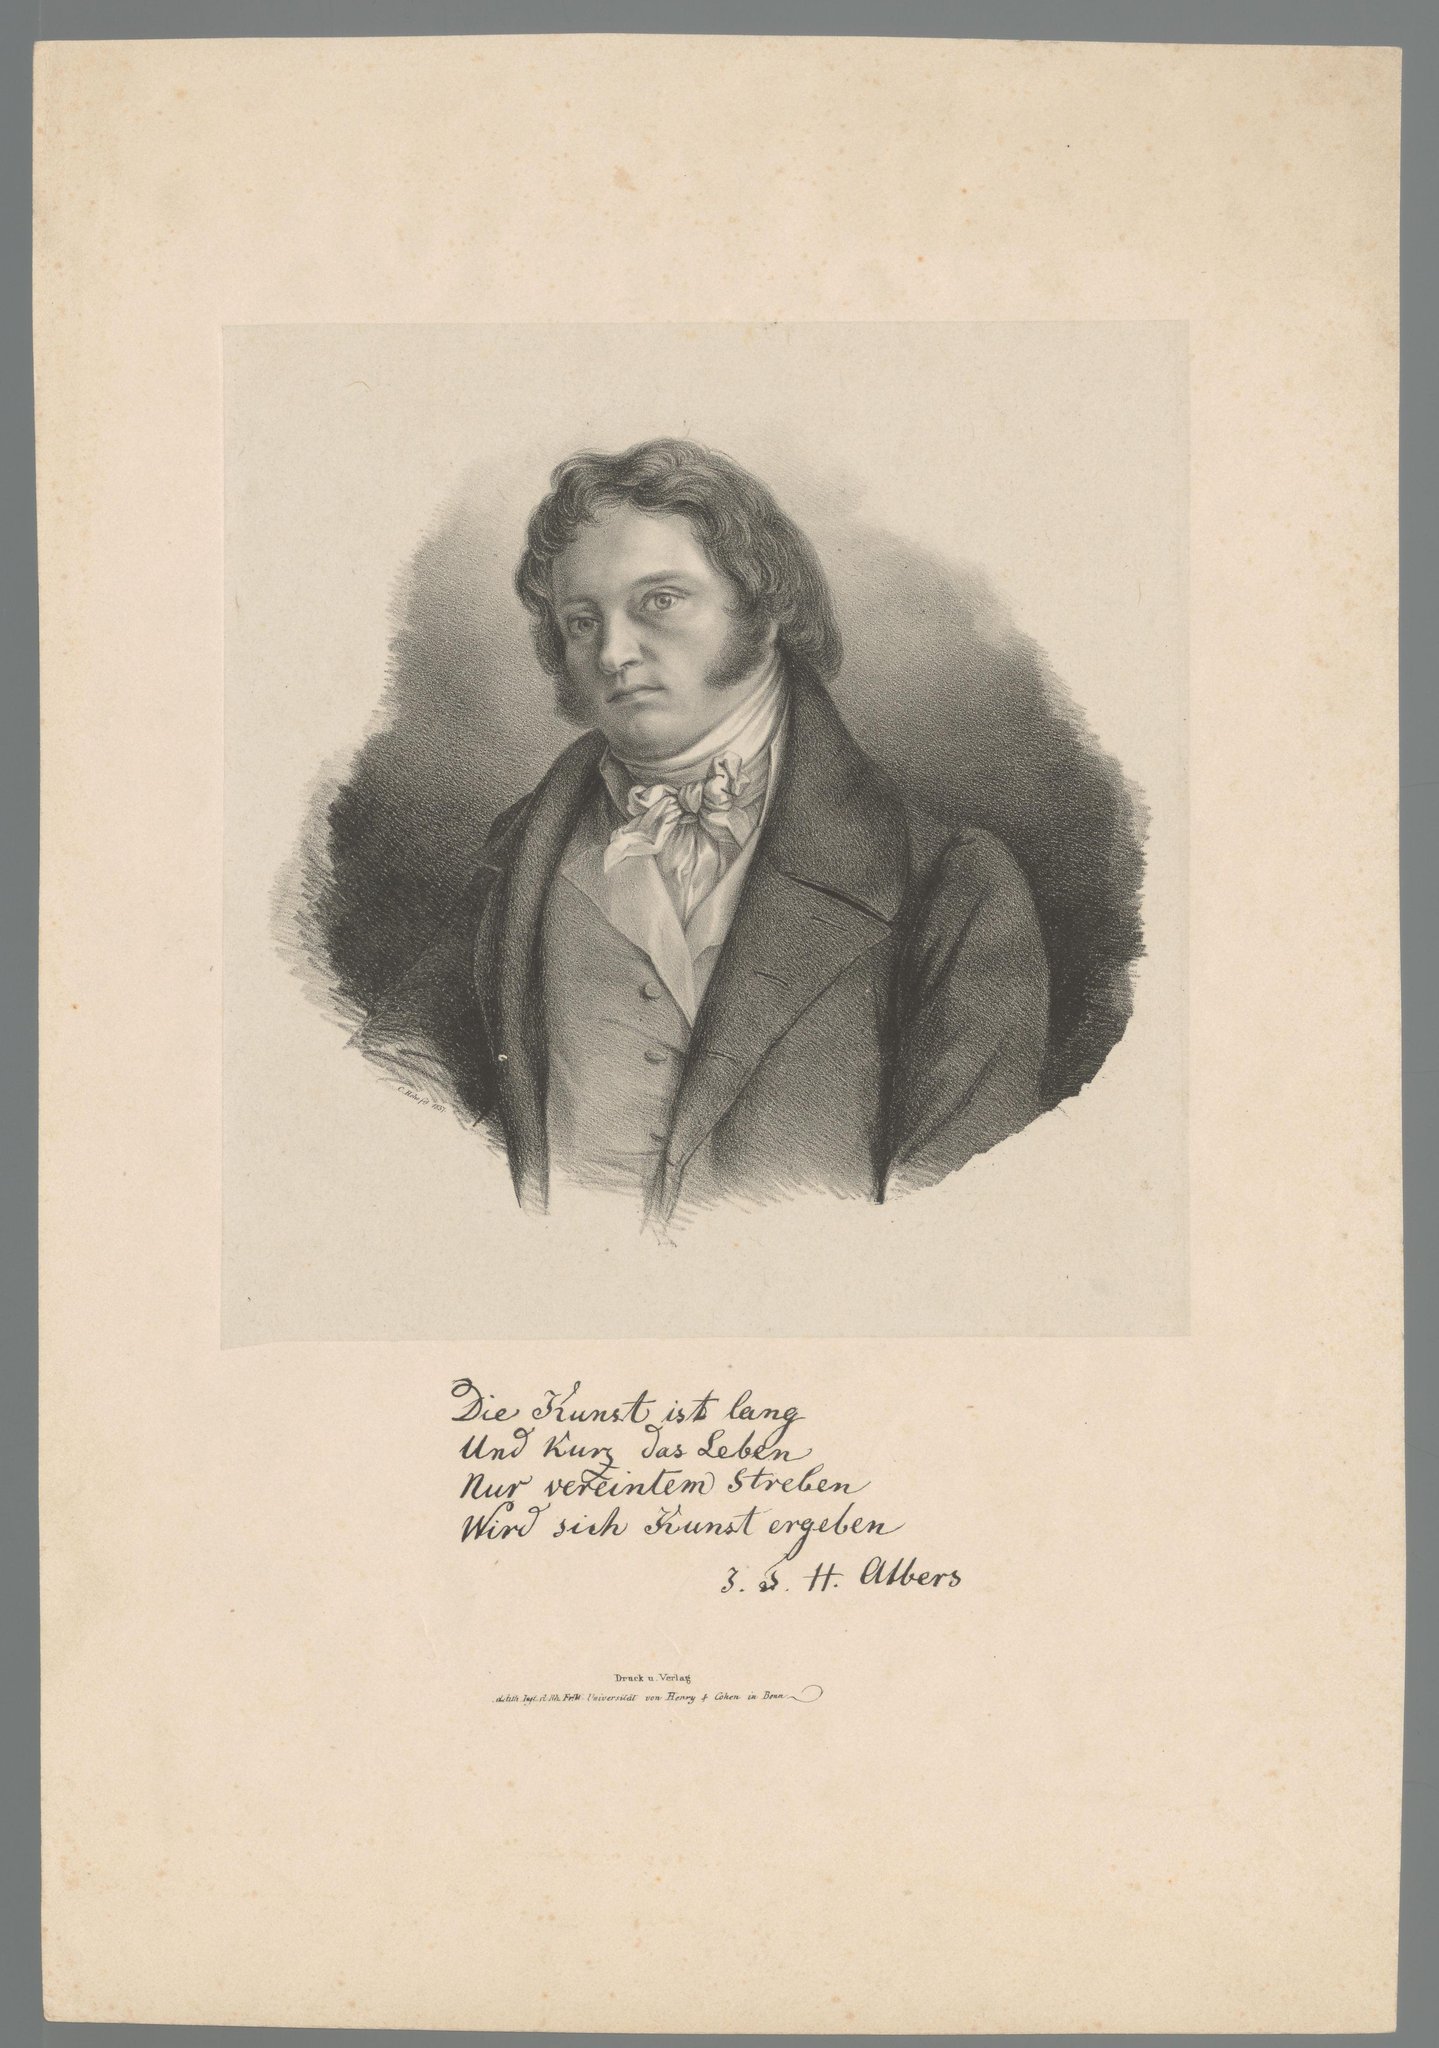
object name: print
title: Portret van een onbekende man, mogelijk Albers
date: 1837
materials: paper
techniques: lithograph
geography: bonn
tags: adult man, historical persons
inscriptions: collector's mark: Lugt 2228